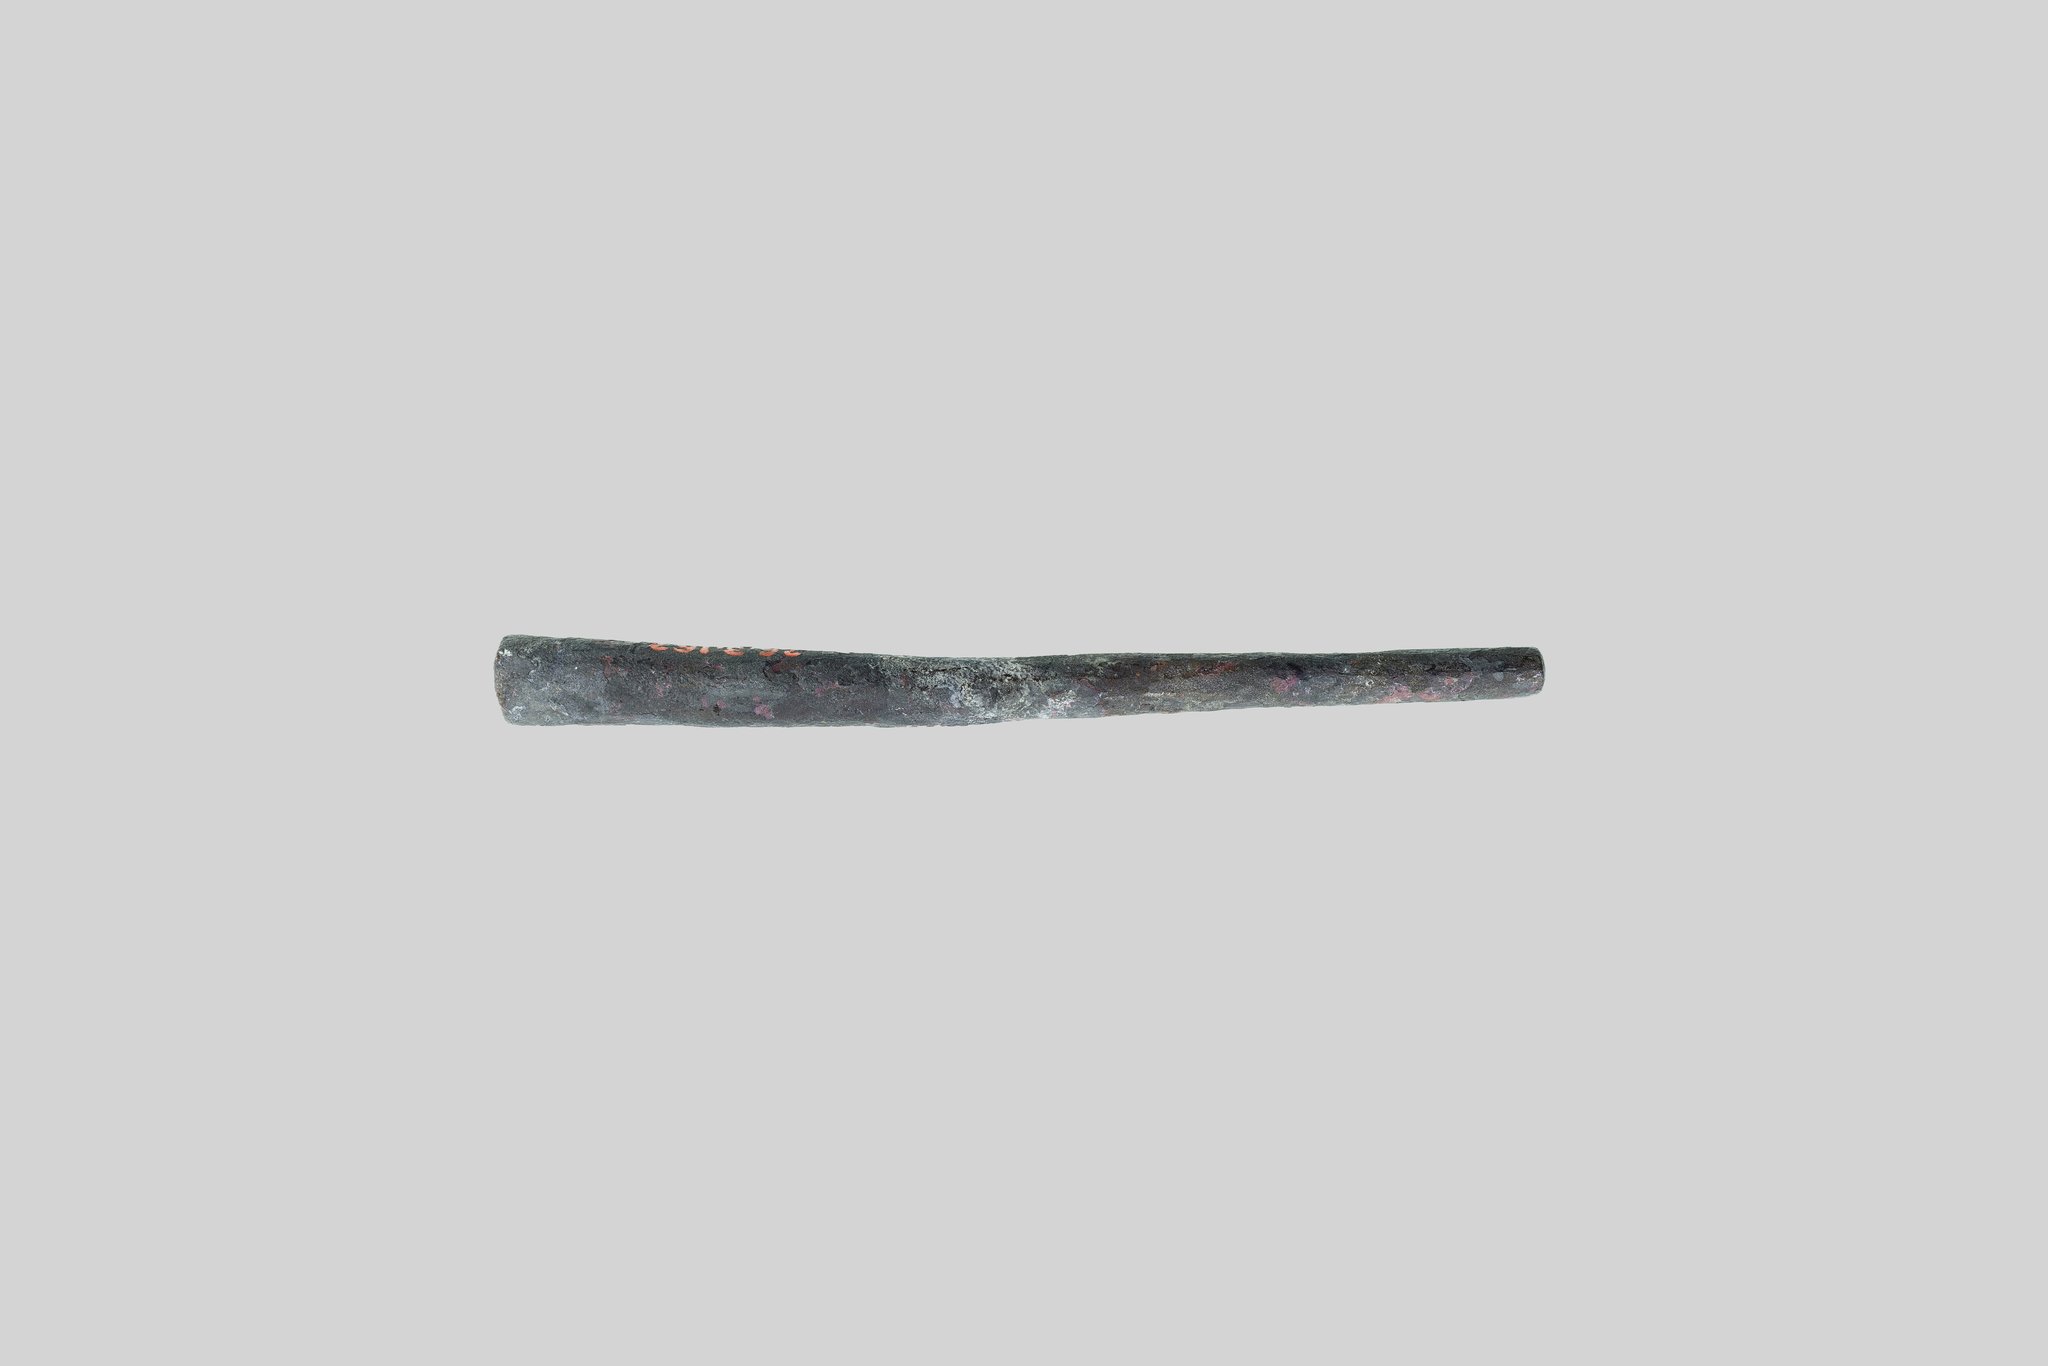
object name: pestle, nespekashuty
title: Pestle?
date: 664-610 BCE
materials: lead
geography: egypt